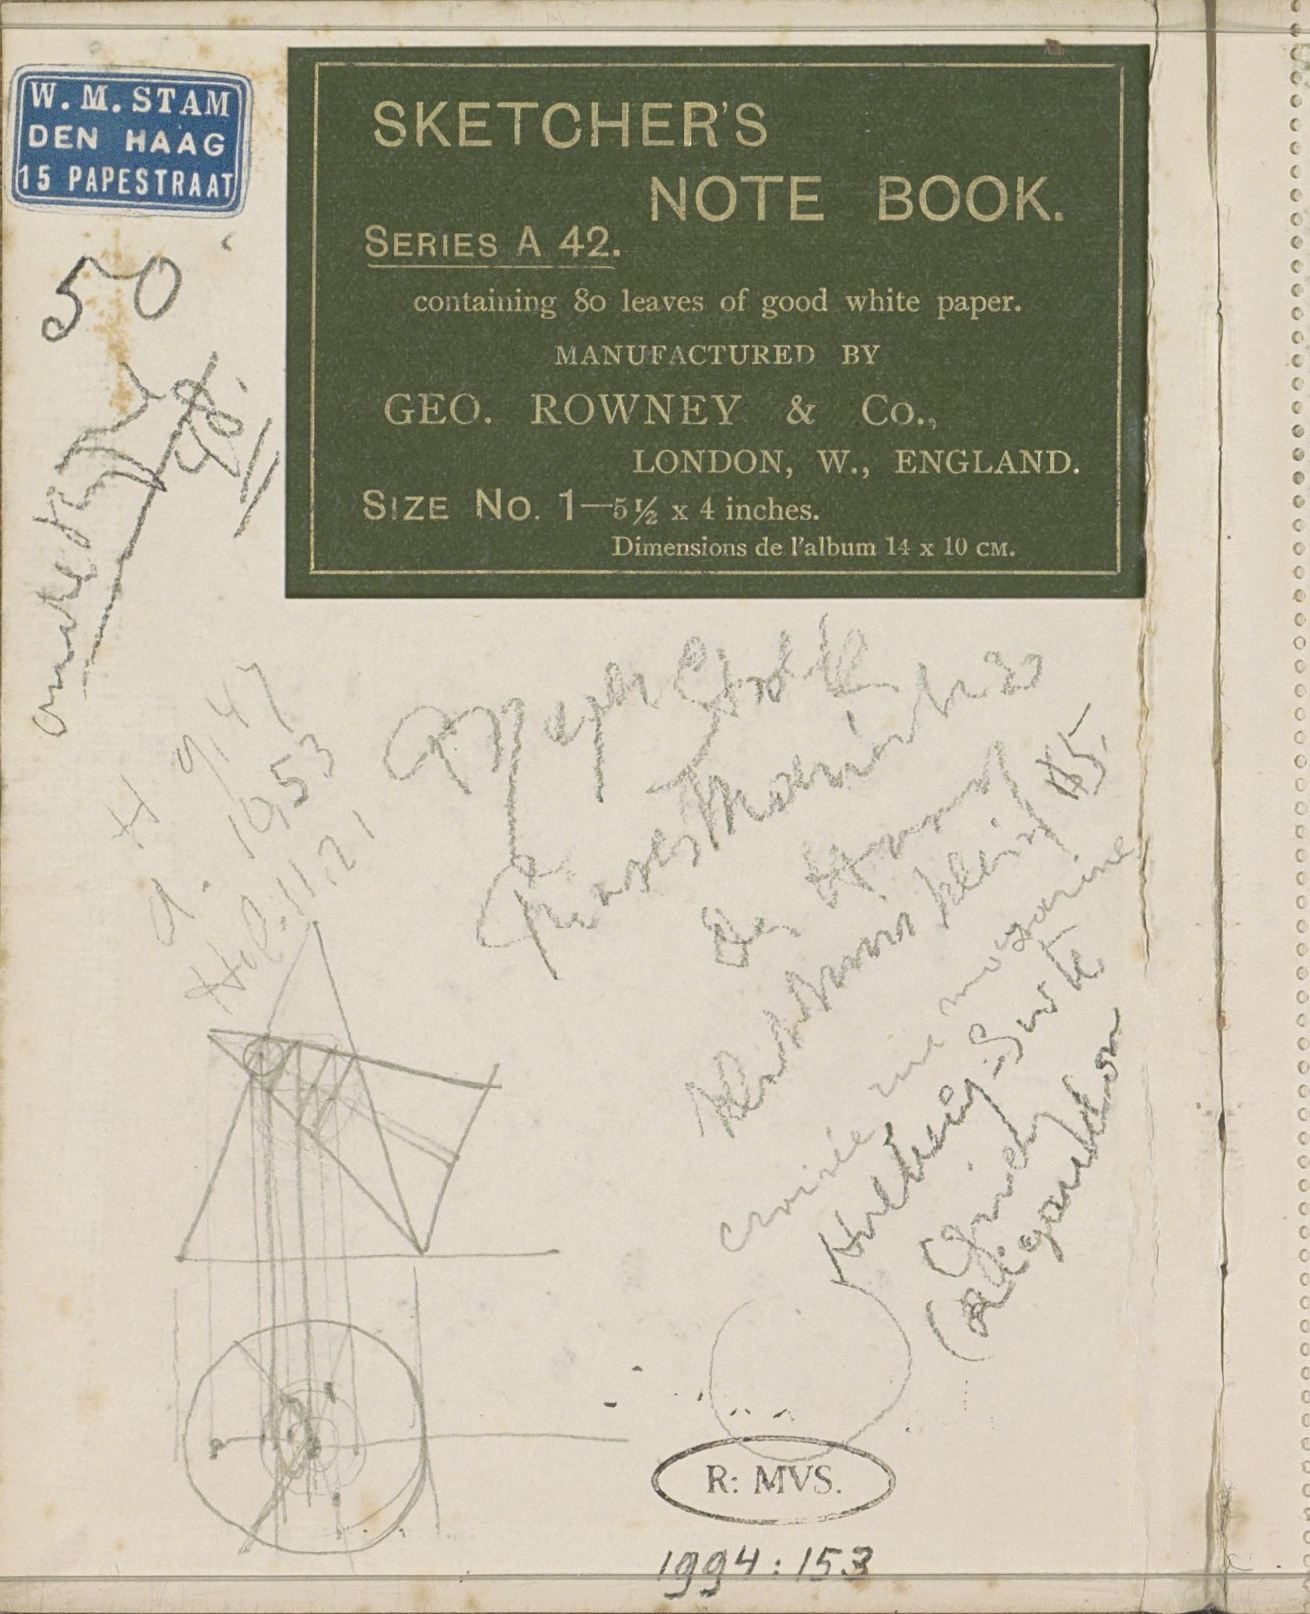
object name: sketchbook leaf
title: Driehoeken en een cirkel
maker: reijer stolk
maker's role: draughtsman, print maker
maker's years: 1896-1945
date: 1906-1945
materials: paper, pencil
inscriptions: factory mark: ‘SKETCHER’S/ NOTE BOOK/ SERIES A 42./ containing 80 leaves of good white paper./ MANUFACTURED BY/ GEO. ROWNEY 7 Co.,/ LONDON, W., ENGLAND./ SIZE No. 1 – 5 ½ x 4 inches./ Dimensions de l’album 14 x 10 CM.’, collector's mark: Lugt 2228a, address: ‘[...] Reyer Stolk/ [...] Molen 33/ den Haag [...]’, retailer's mark: ‘W.M. STAM/ DEN HAAG/ 15 PAPESTRAAT’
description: Voorste schutblad uit een schetsboek met 42 bladen.